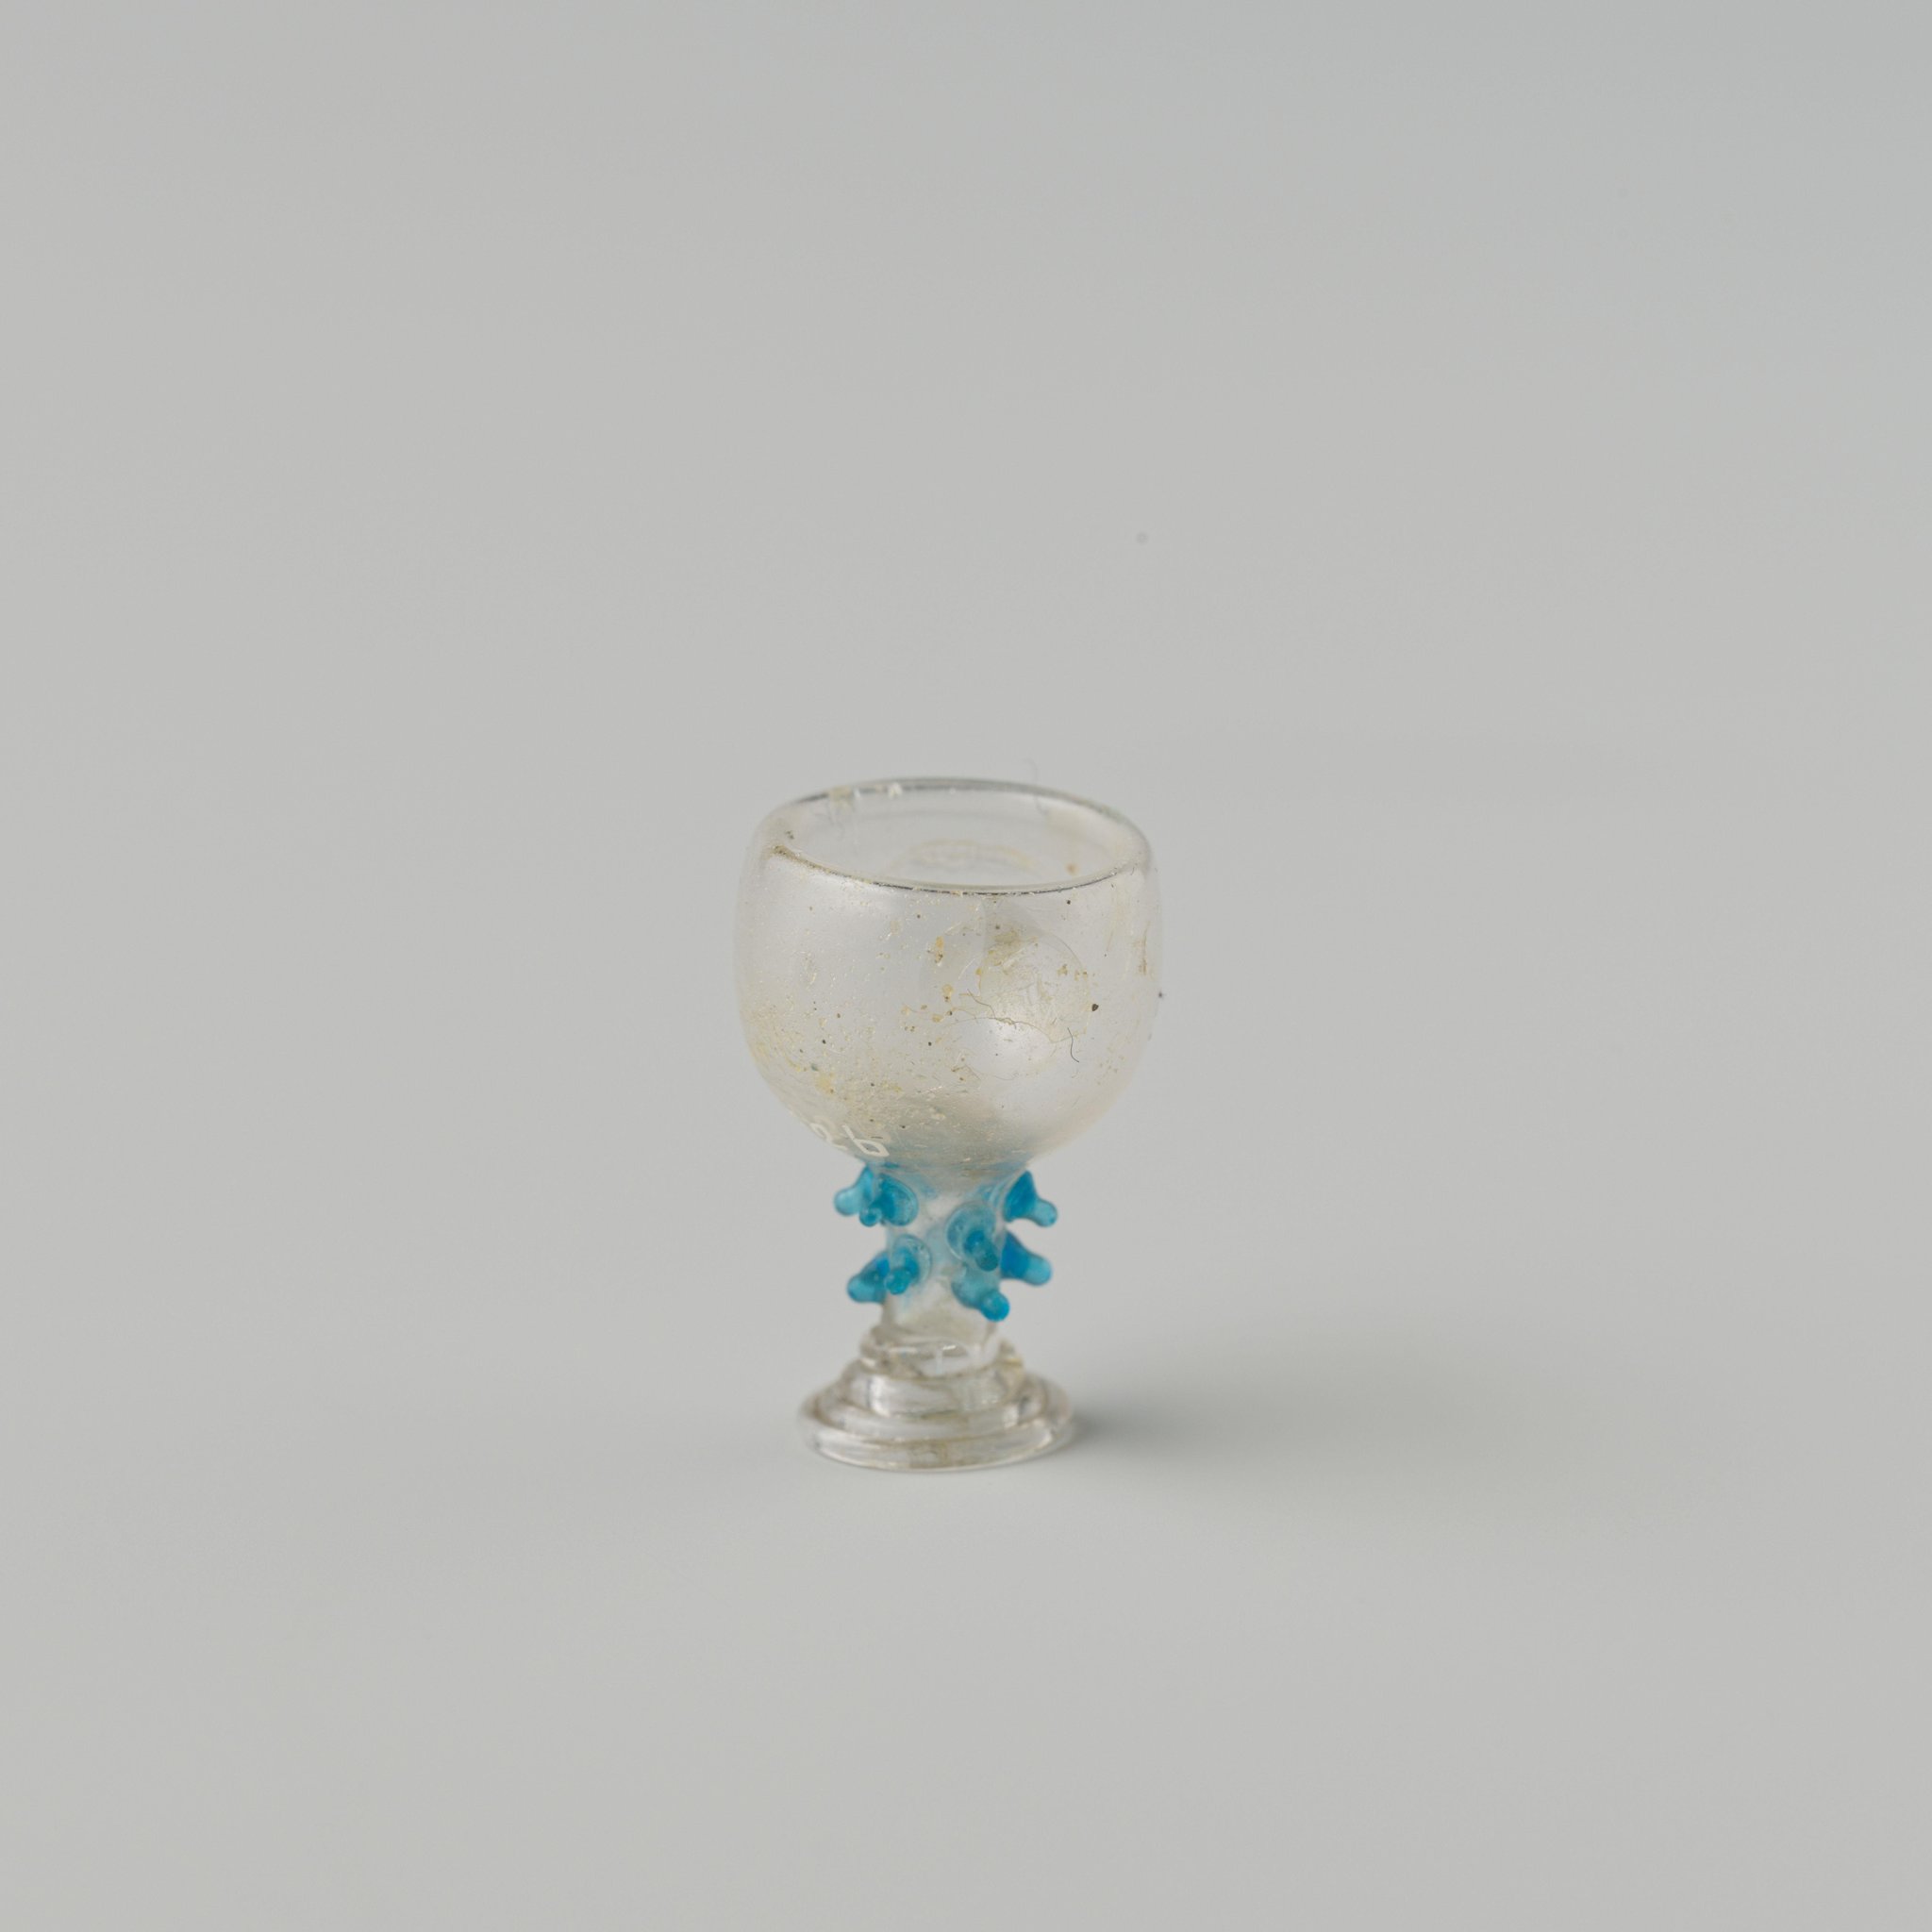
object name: roemer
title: Roemer van helder kleurloos glas met blauwe noppen op de schacht; cuppa dubbelwandig; voet van gespannen glasdraad.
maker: Anonymous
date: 1675-1710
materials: glass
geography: amsterdam